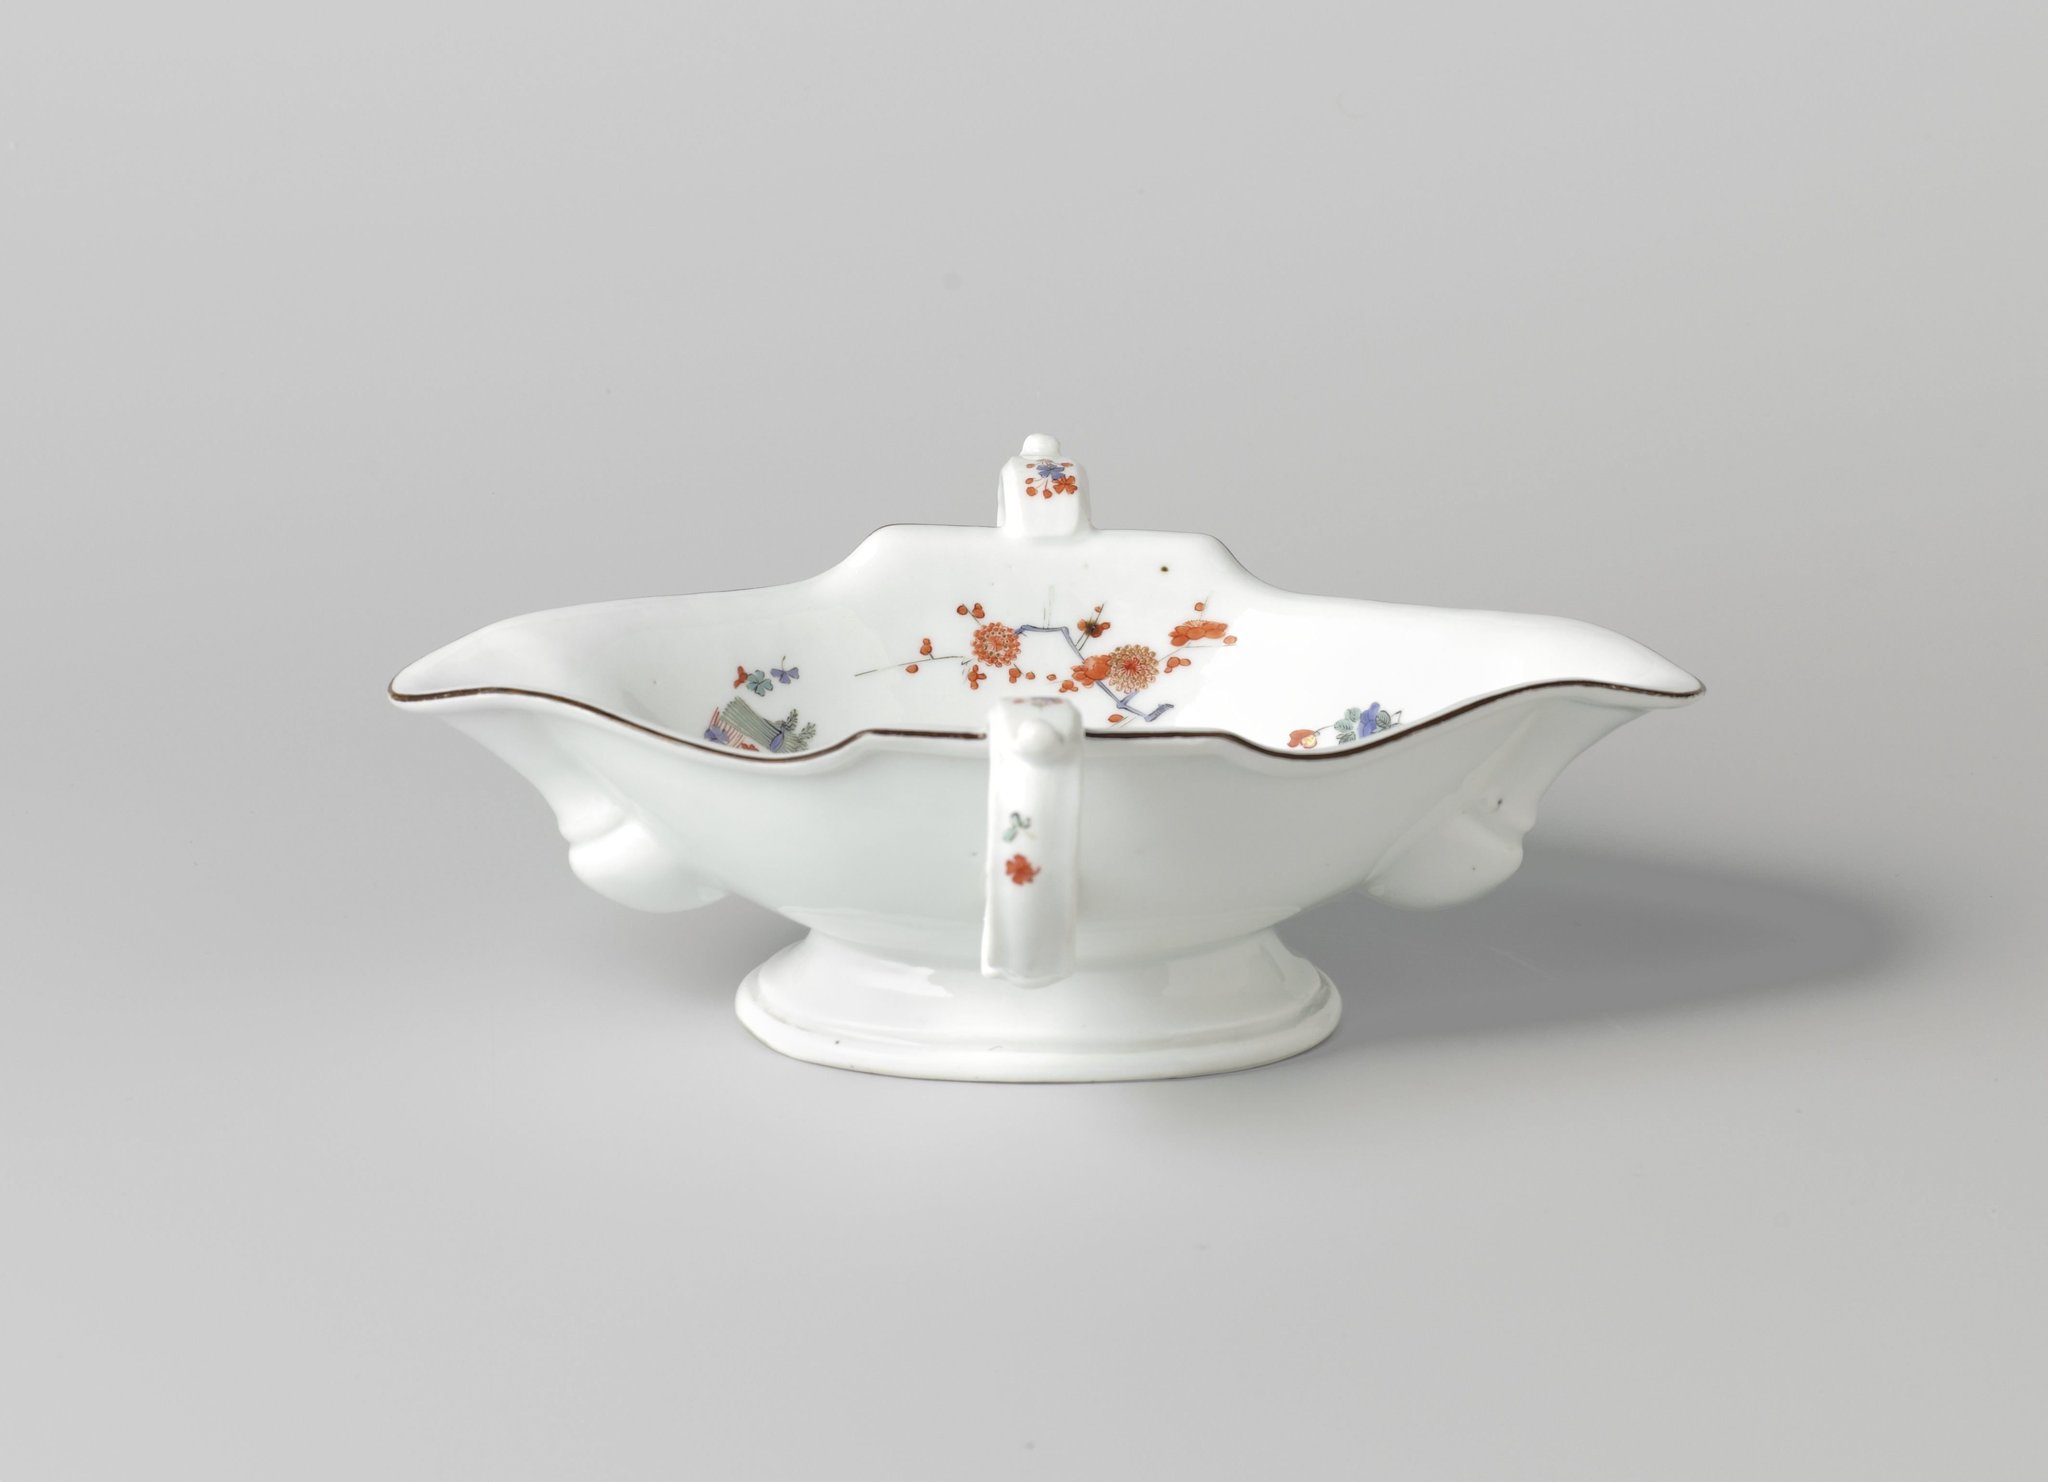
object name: sauceboat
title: Sauskom, veelkleurig beschilderd met een Kakiemon-decor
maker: adam friedrich von löwenfinck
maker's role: porseleinschilder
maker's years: 1714-1754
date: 1730-1735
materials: porcelain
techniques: painted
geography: meissen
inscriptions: mold mark, mark: ‘L’, factory mark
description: Plate. Meissen, c. 1740 - 1750. Sauceboat. Meissen, c. 1730 - 1735.